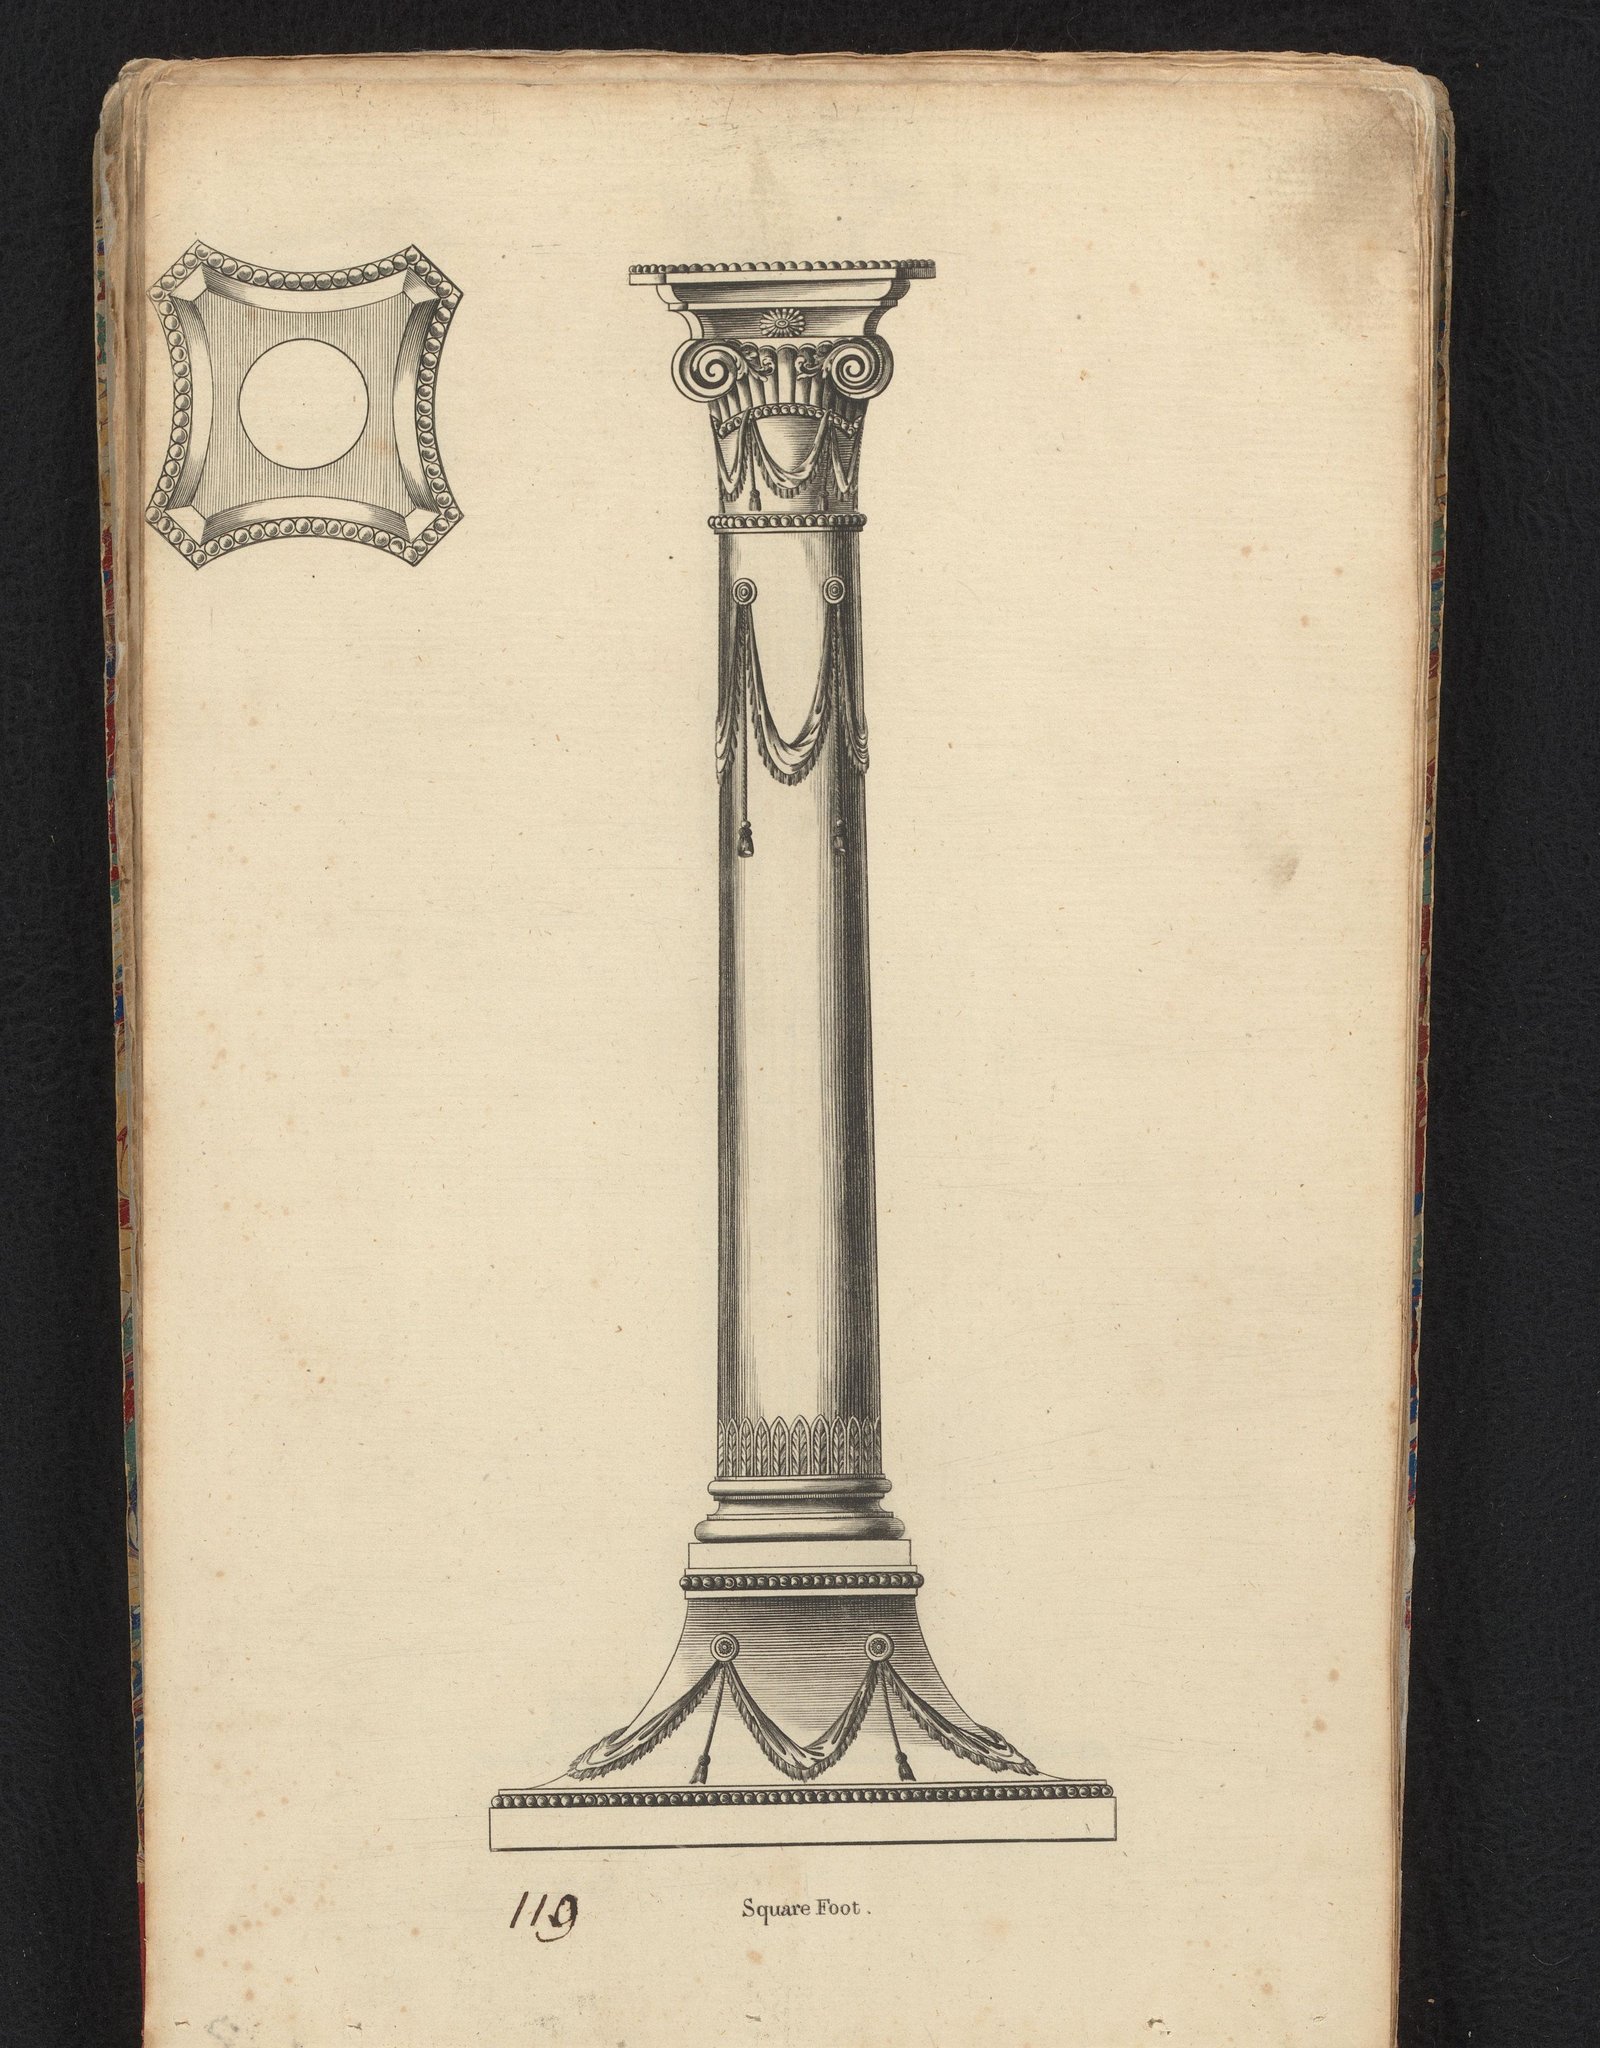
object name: album leaf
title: Ontwerp voor een kandelaar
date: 1784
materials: paper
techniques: engraving, etching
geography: england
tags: candlestick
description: Ontwerp voor een kandelaar met een vierkante voet, op het volle blad. Met detail van de voet. Met gedrukt onderschrift en handgeschreven nr. 119. Onderdeel van een catalogus met assortiment modellen van Sheffield verzilverd vaatwerk (pleet) door Matthew Boulton.